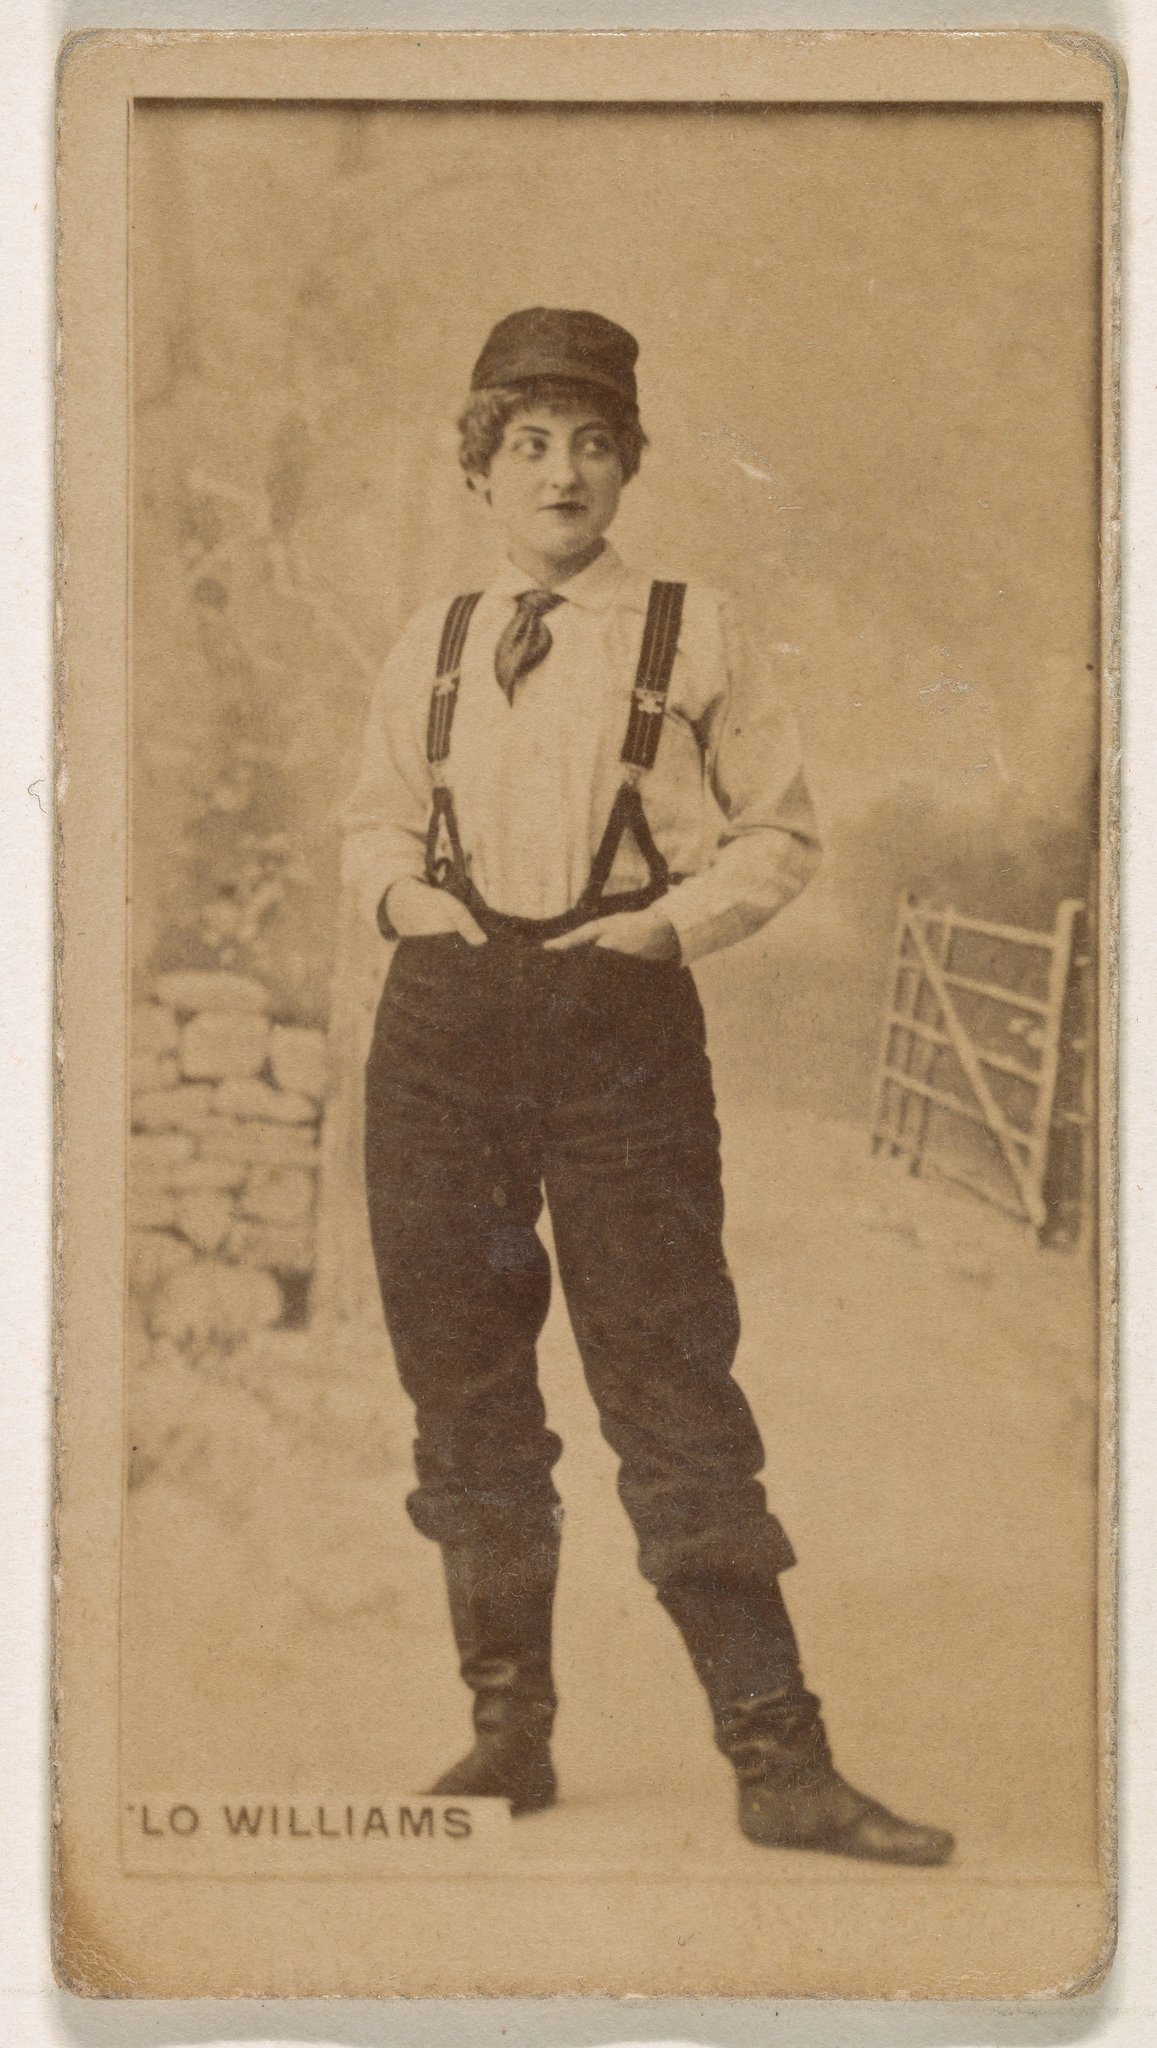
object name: photograph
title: Flo Williams, from the Actresses series (N245) issued by Kinney Brothers to promote Sweet Caporal Cigarettes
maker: kinney brothers tobacco company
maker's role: publisher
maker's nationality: american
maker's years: 1869-2011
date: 1890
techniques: albumen silver print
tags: portraits,women,actresses